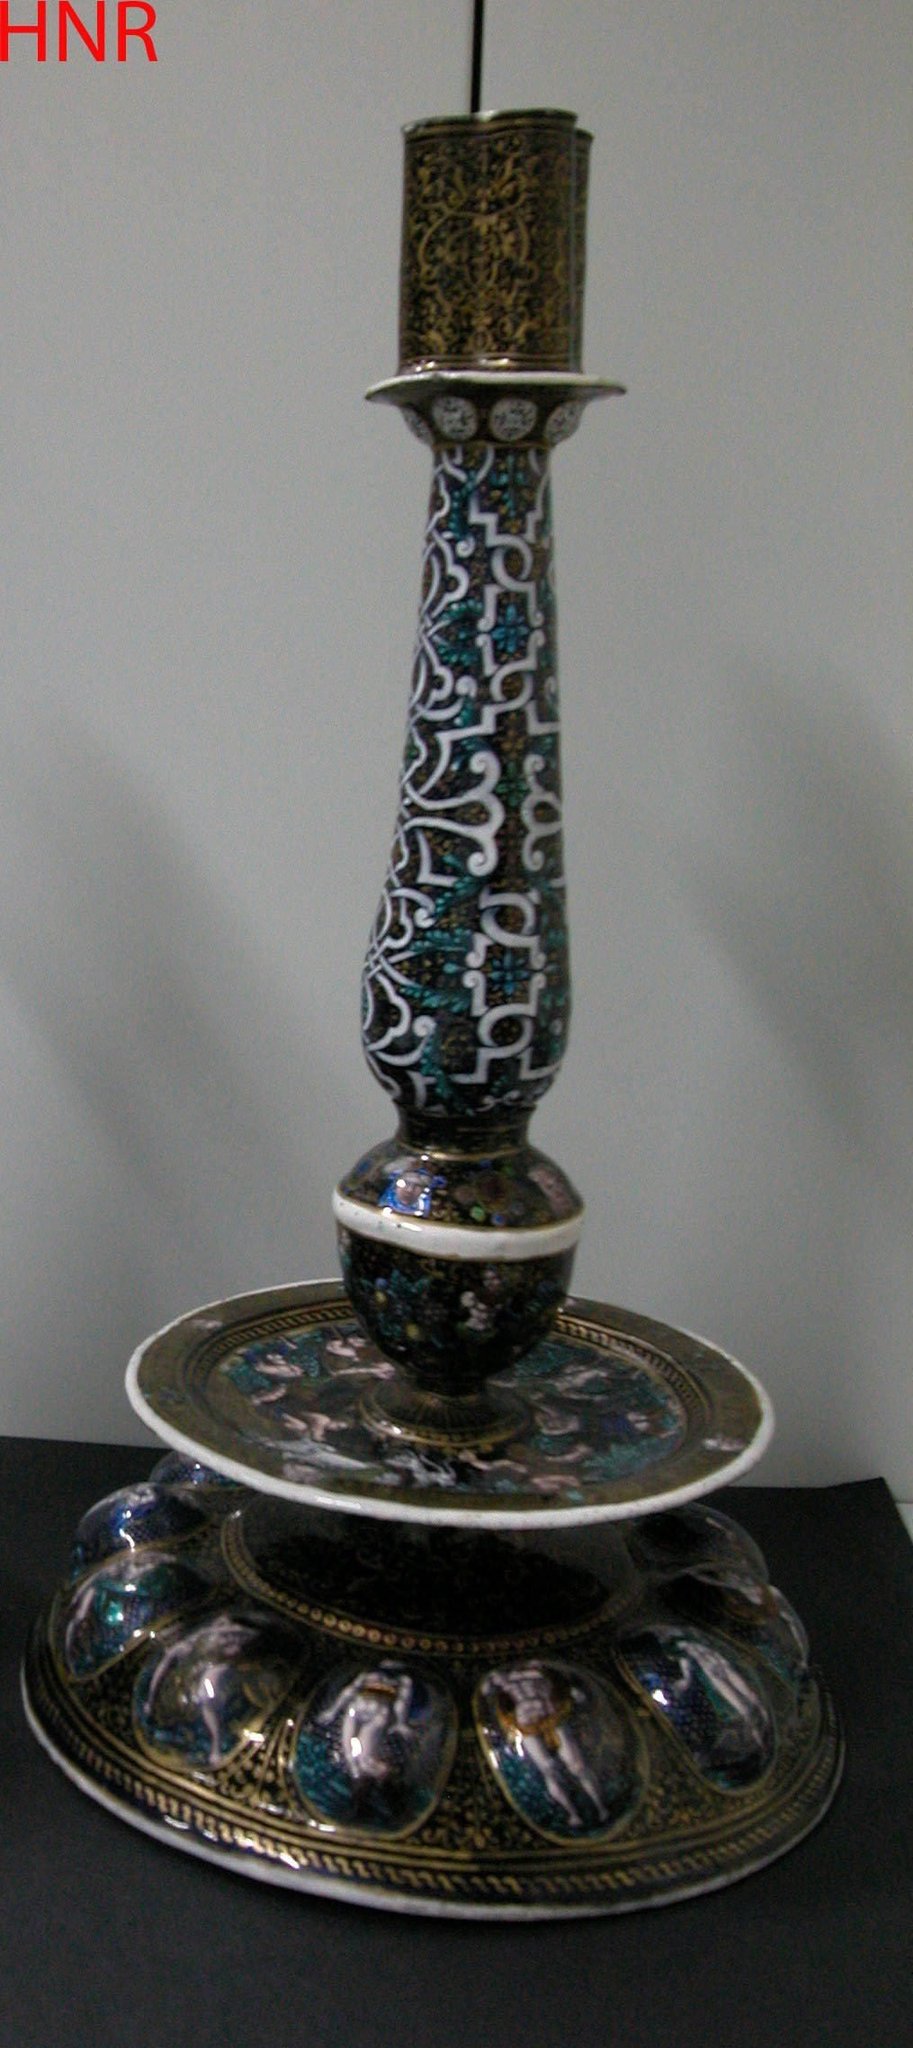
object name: candlestick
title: Pair of candlesticks with gods and the Labours of Hercules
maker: jean court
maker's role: emailleschilder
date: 1550-1600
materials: copper, gold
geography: limoges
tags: most important deeds of hercules: the twelve labours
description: Represented on the round base of the candlesticks are the labours of the Greek hero Hercules, alternating with depictions of Greek gods.